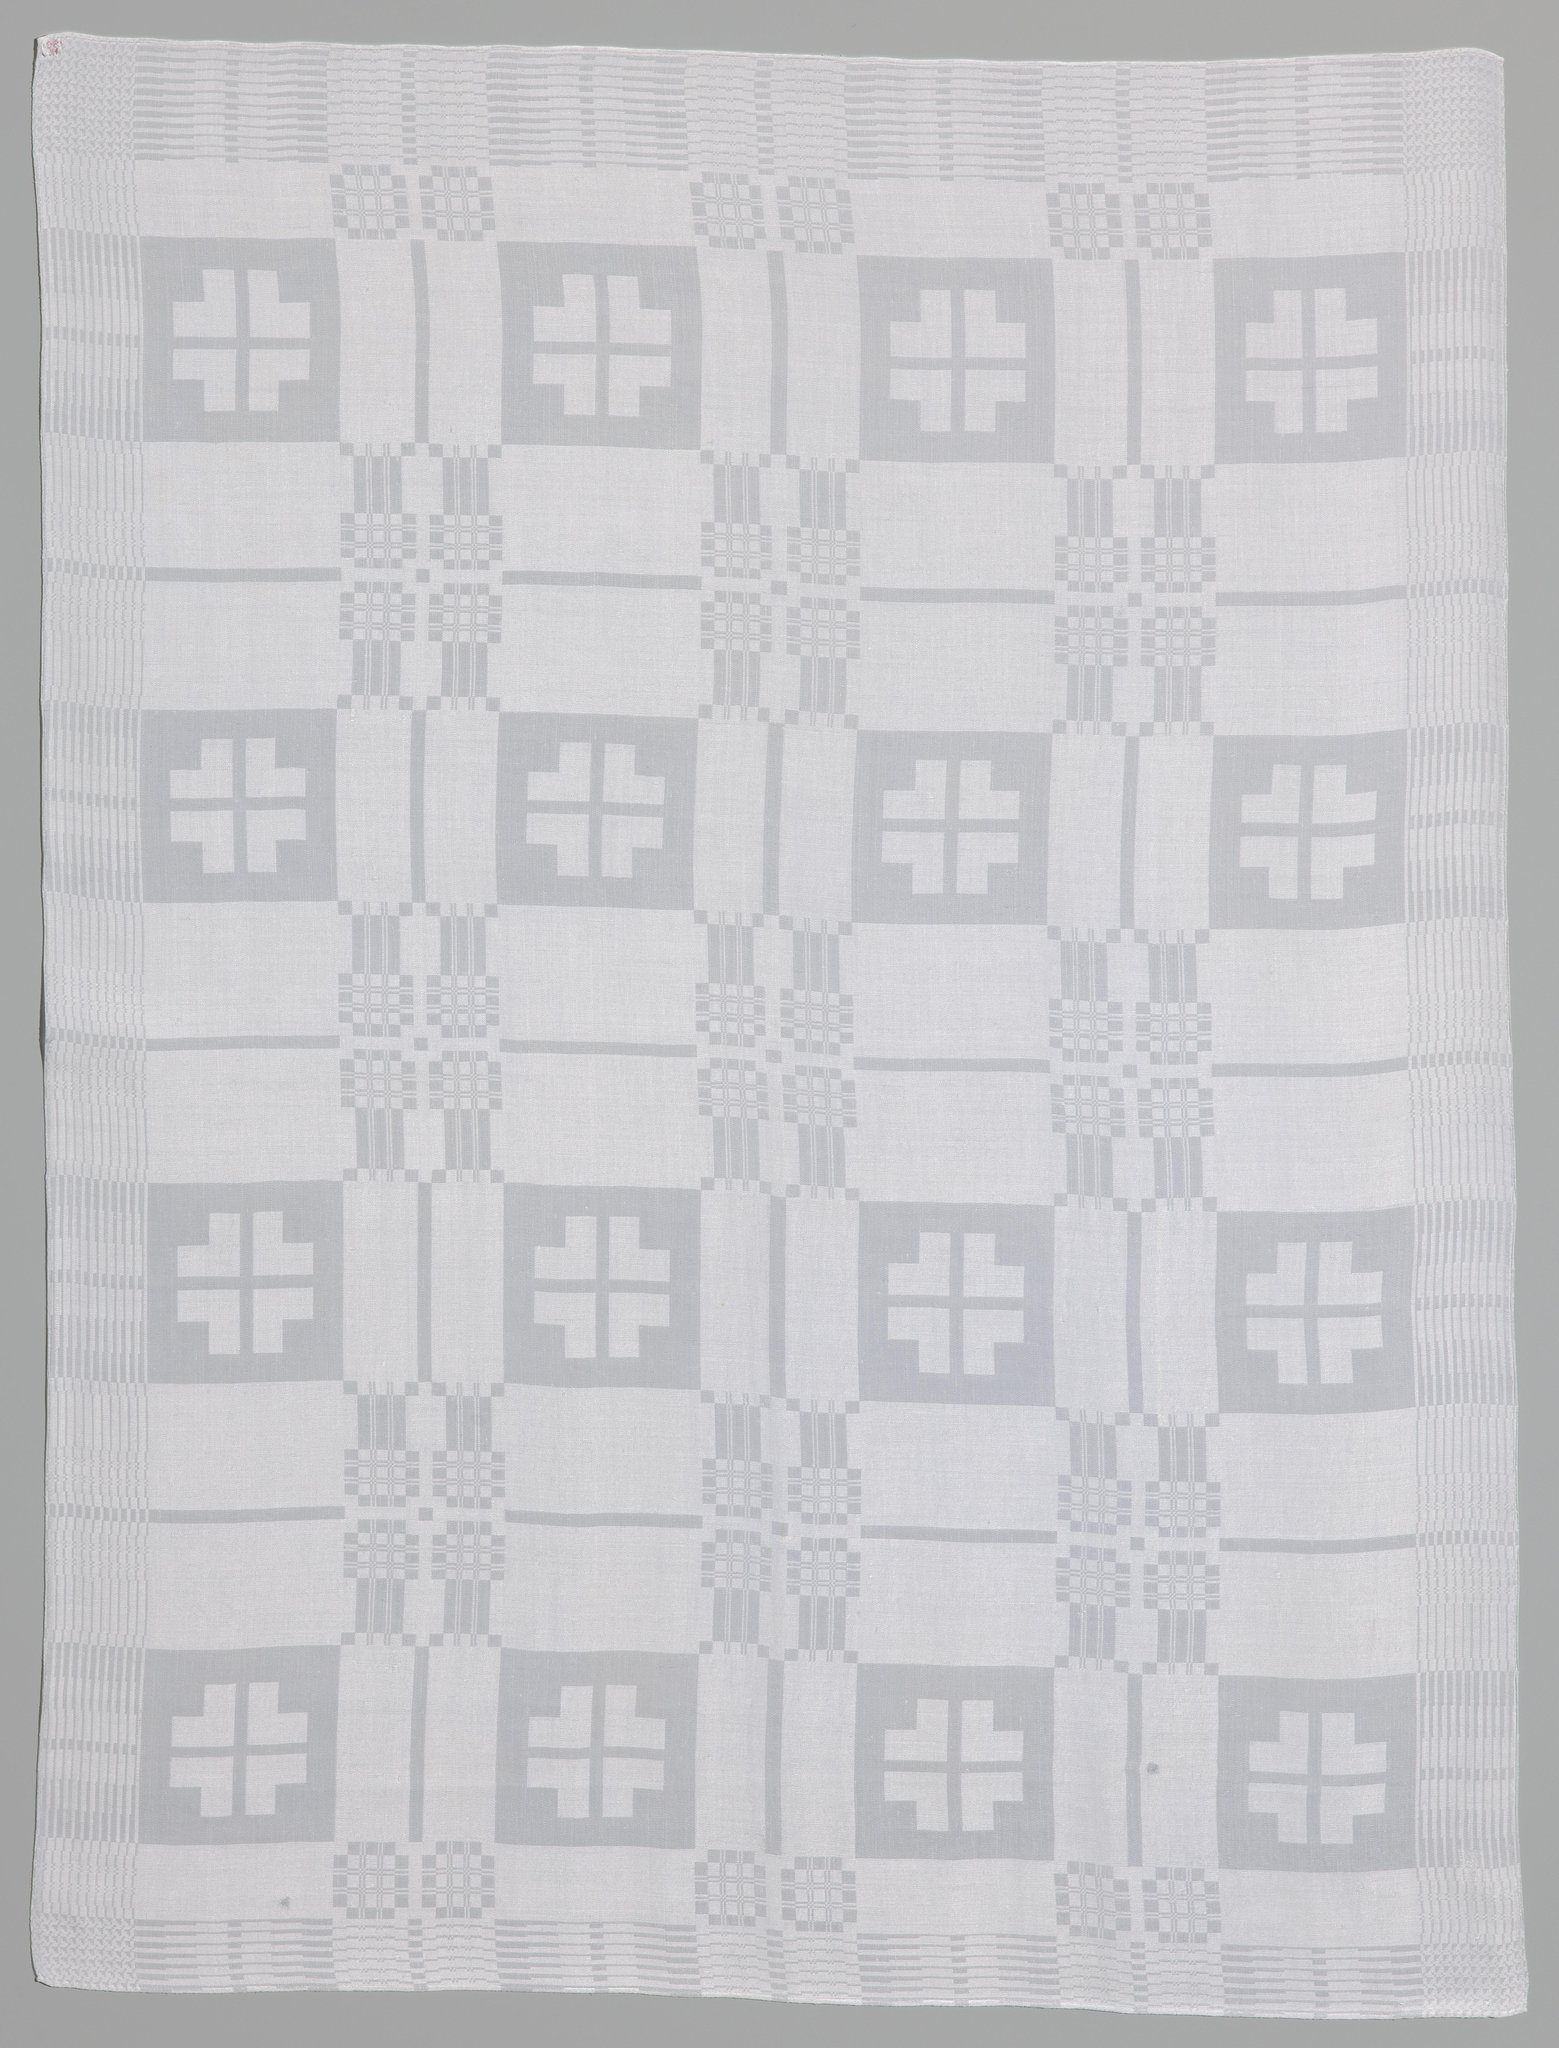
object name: napkin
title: Servet van pellendamast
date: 1800-1900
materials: linen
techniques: cross stitching, weave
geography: north brabant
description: Servet van linnen pellendamast. Het geblokte patroon heeft geruite blokken en vierkanten waarbinnen een kruisvorm. De randen zijn gestreept. Het servet is in rood gemerkt met een kruissteek: DR 114.